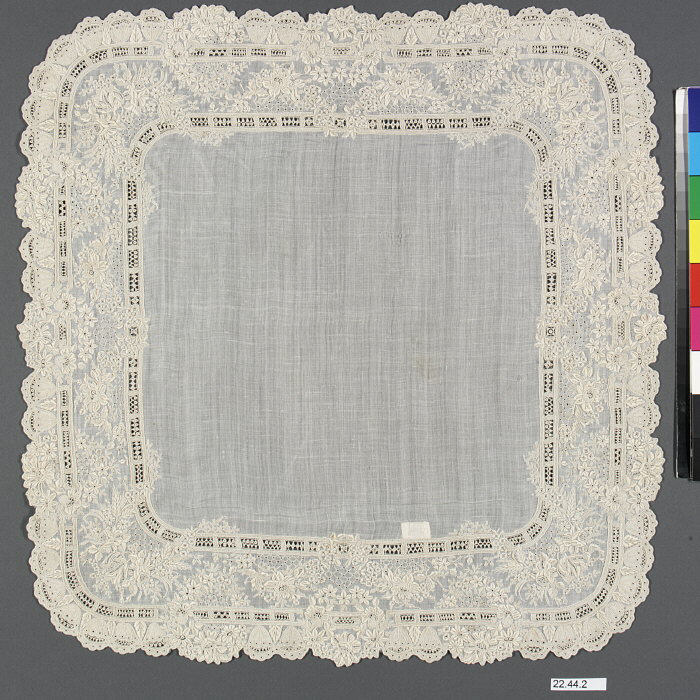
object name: handkerchief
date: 1801-1900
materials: linen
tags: flowers